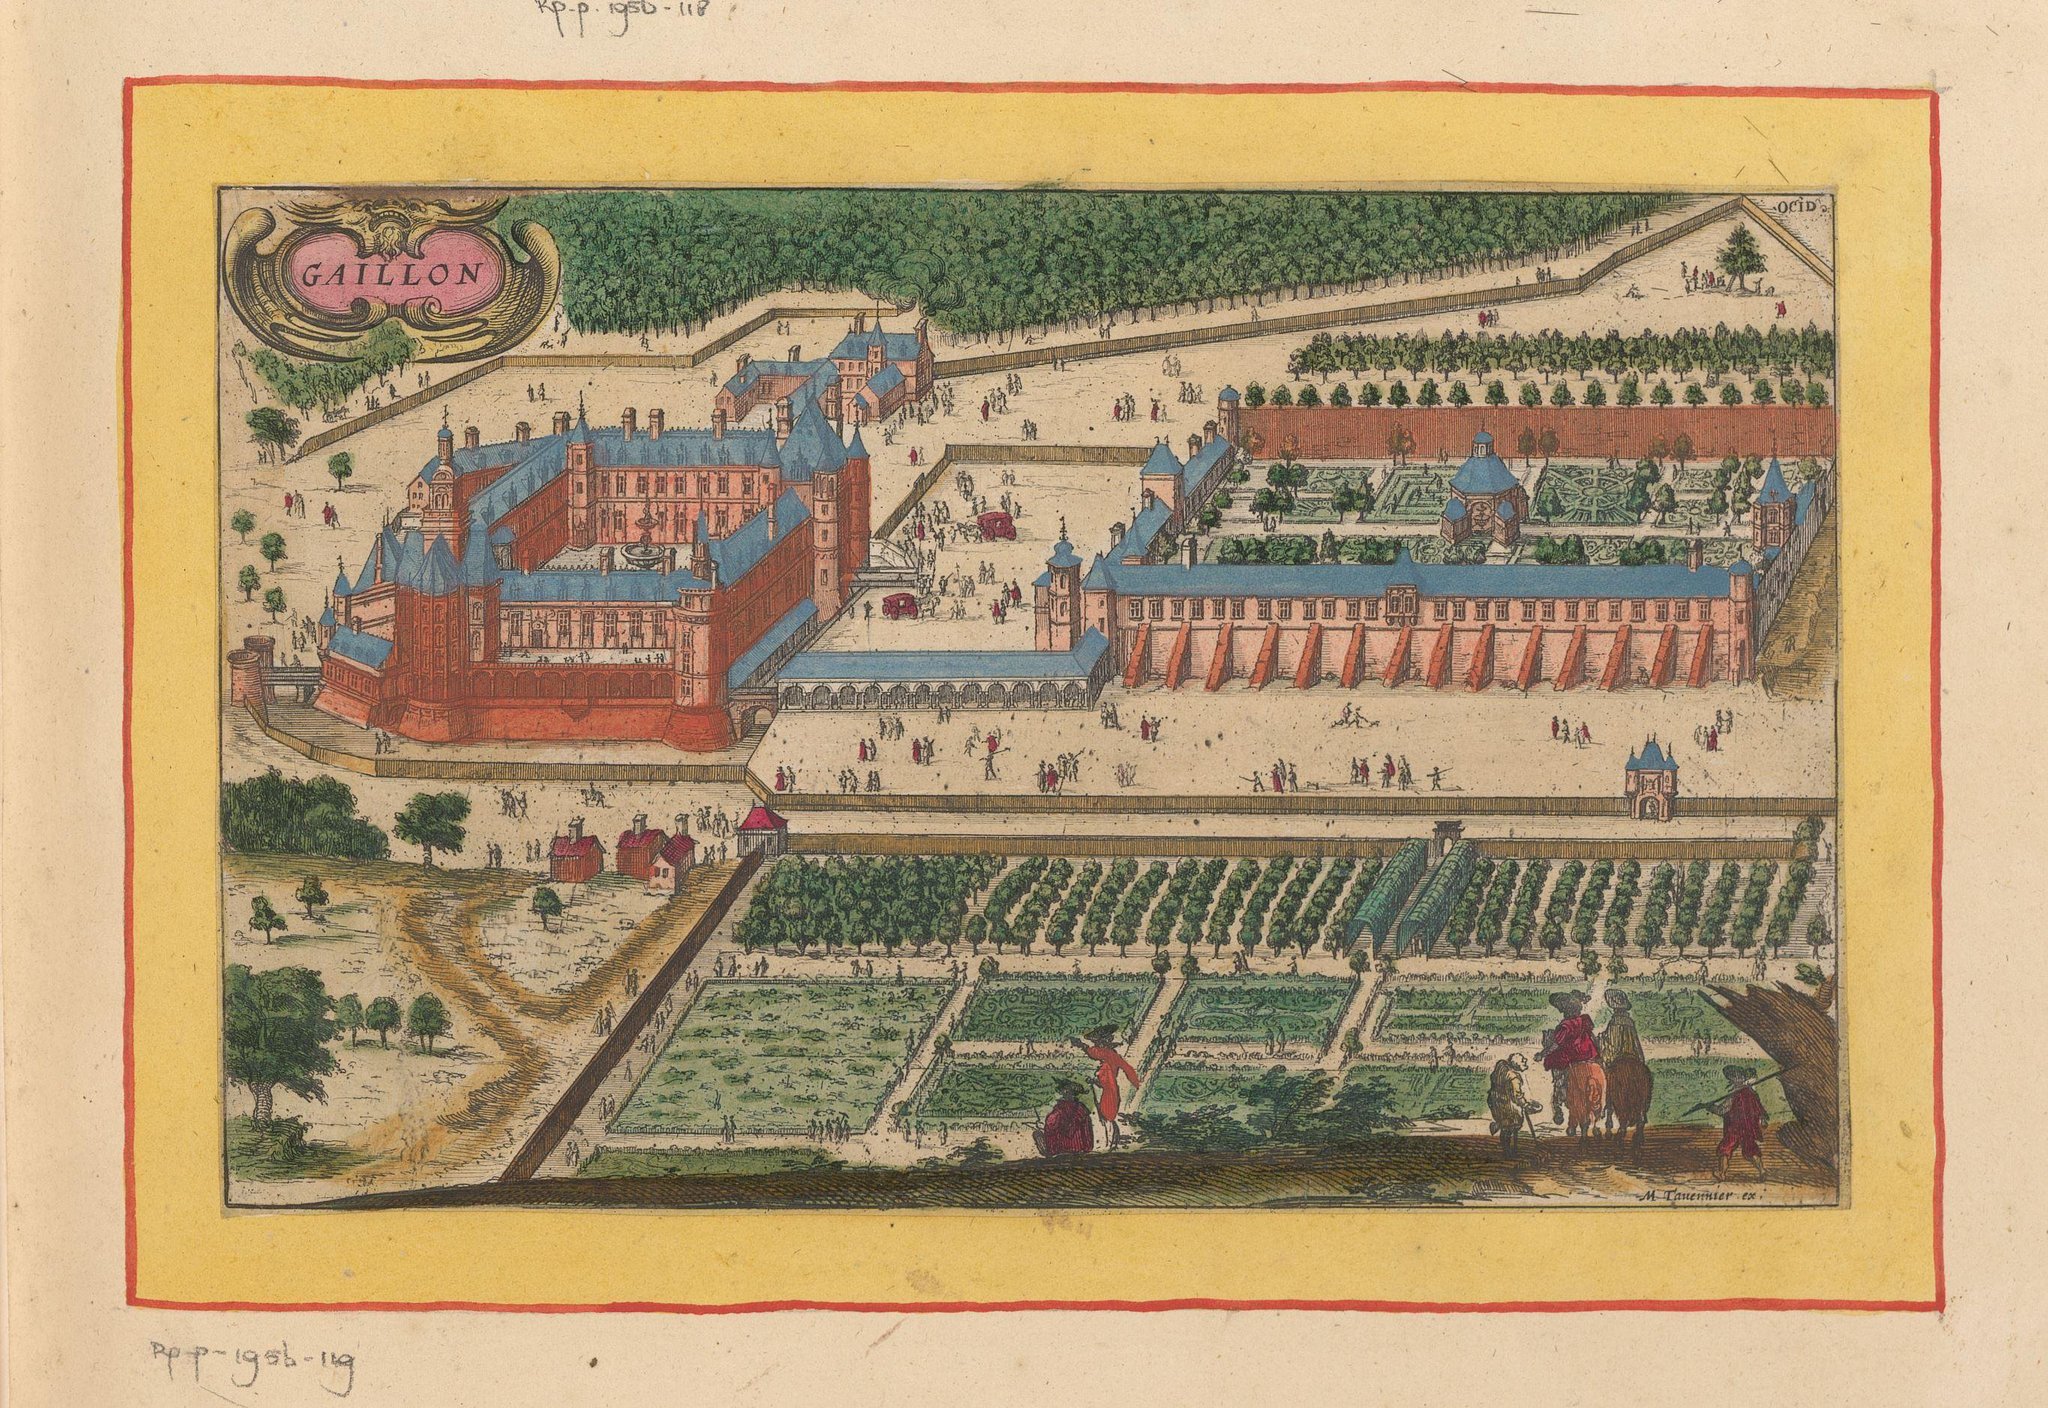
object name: album leaf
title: Gezicht op het kasteel van Gaillon met de tuinen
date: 1609-1644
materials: paper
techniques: engraving, hand coloring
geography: the hague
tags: castle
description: Deze prent maakt deel uit van een album.